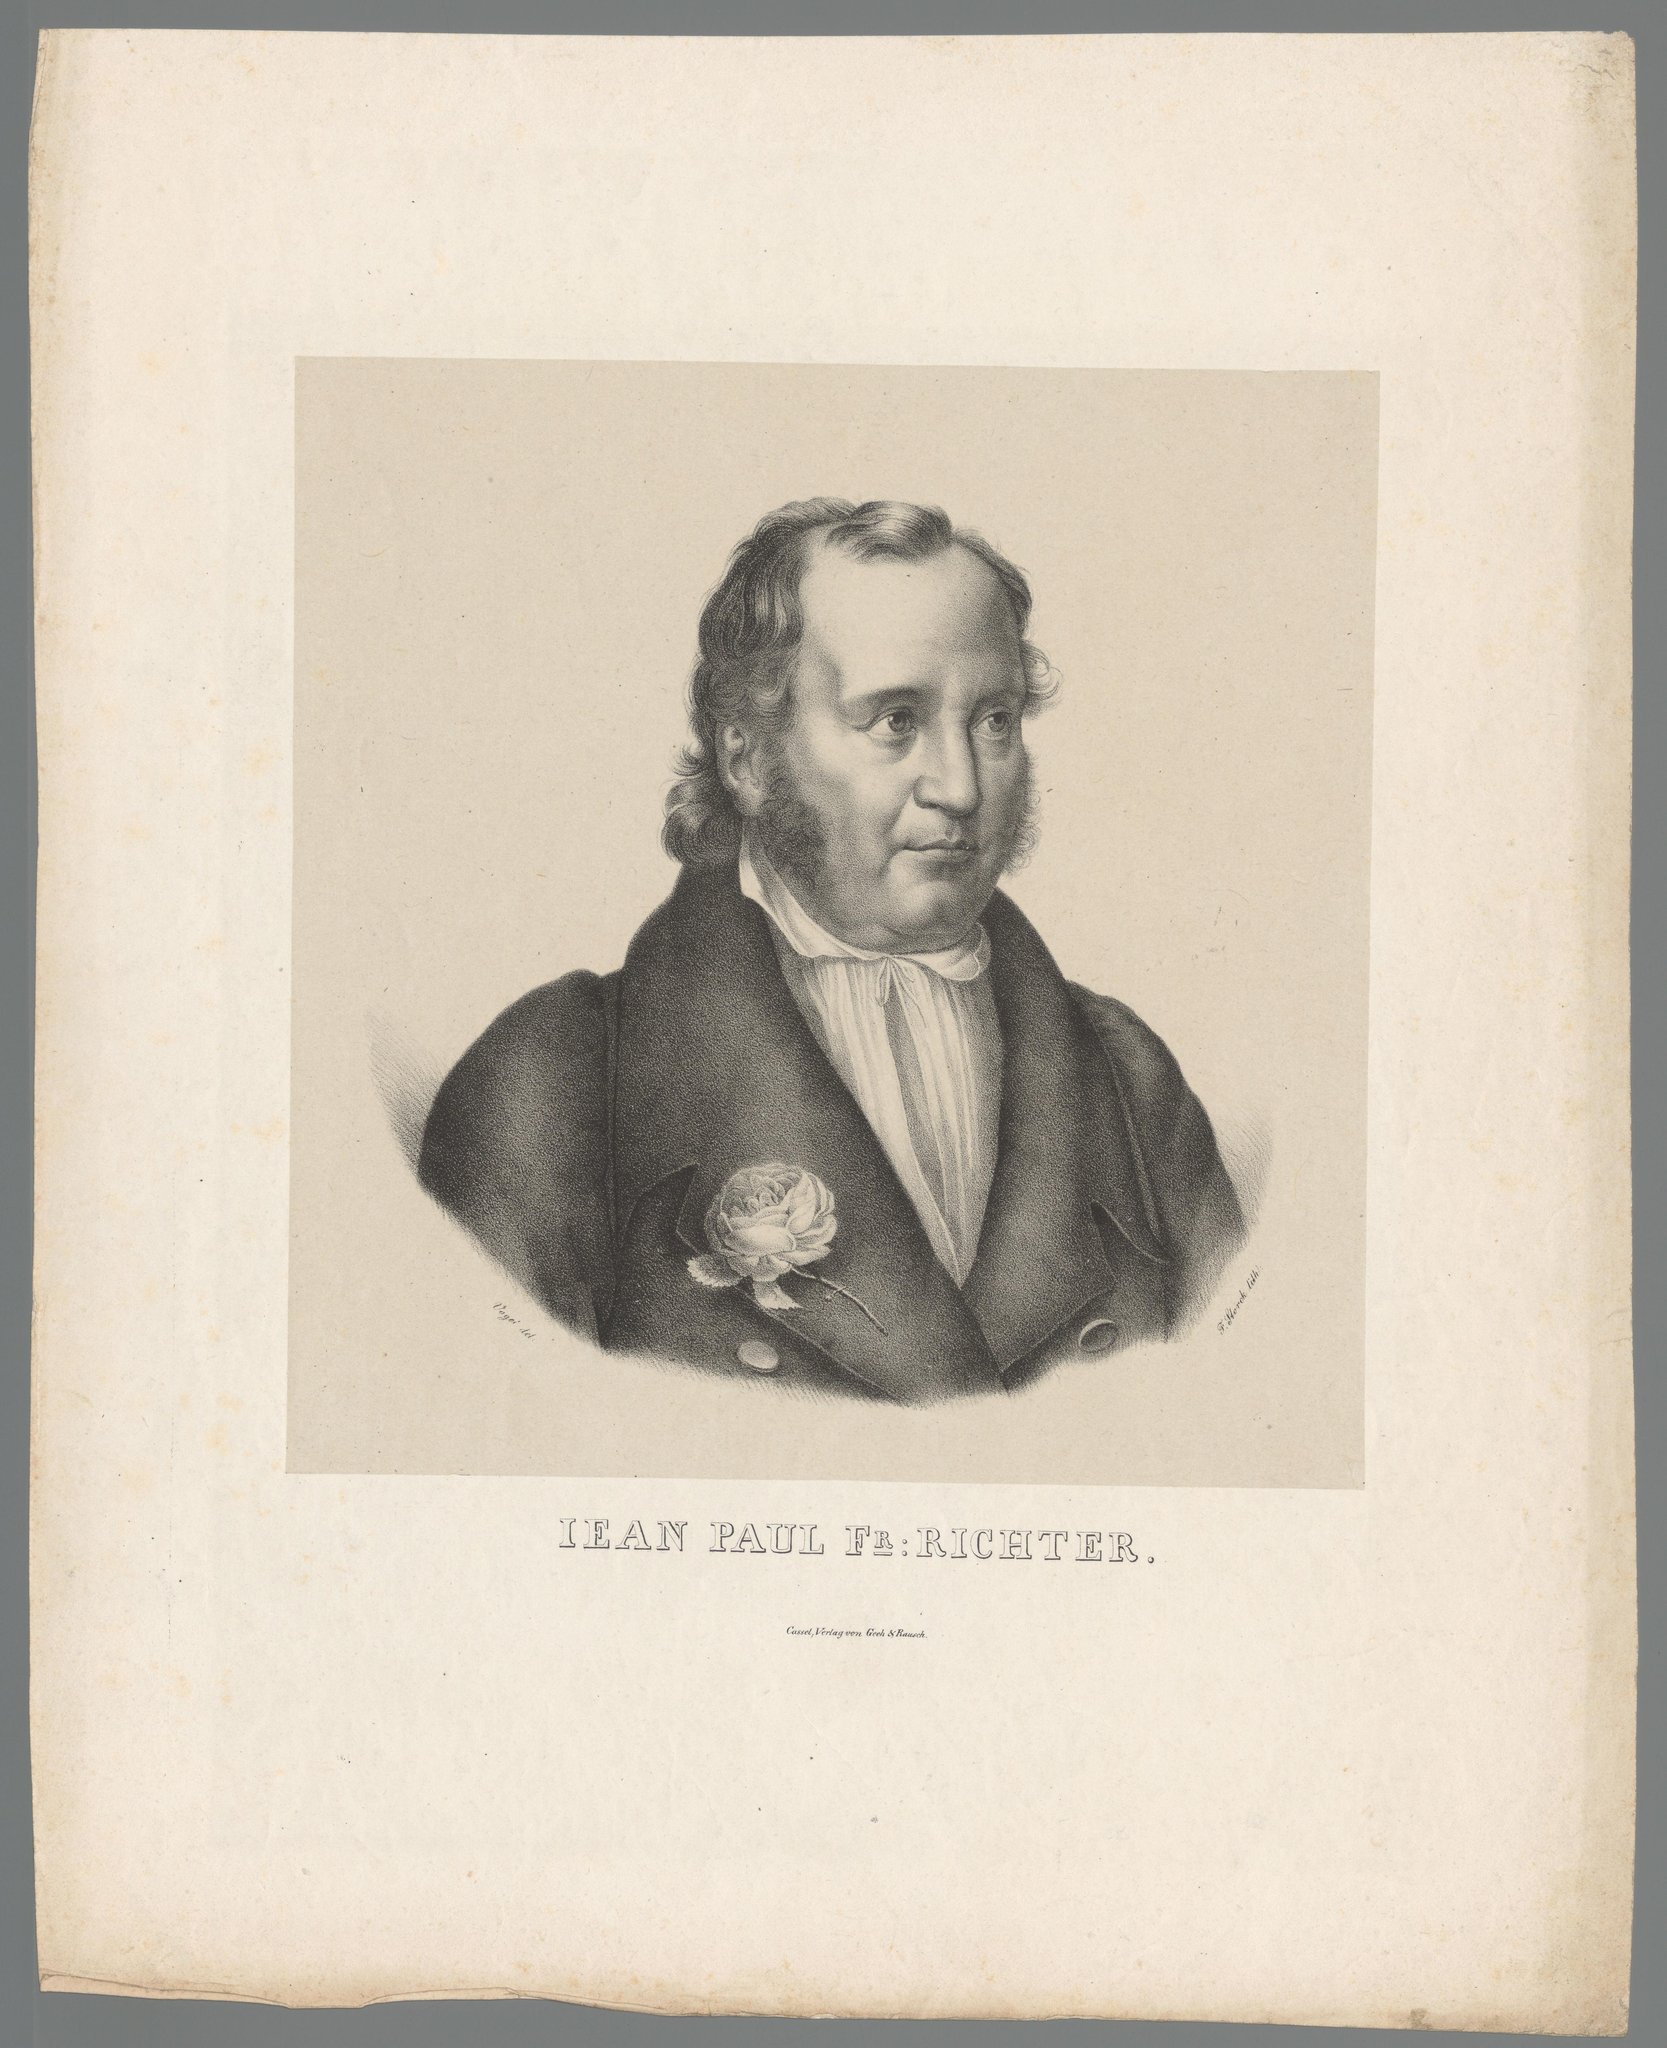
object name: print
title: Portret van Jean Paul Richter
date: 1820-1875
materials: paper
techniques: lithograph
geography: kassel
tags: jean paul, adult man, historical persons, flowers: rose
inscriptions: collector's mark: Lugt 2228